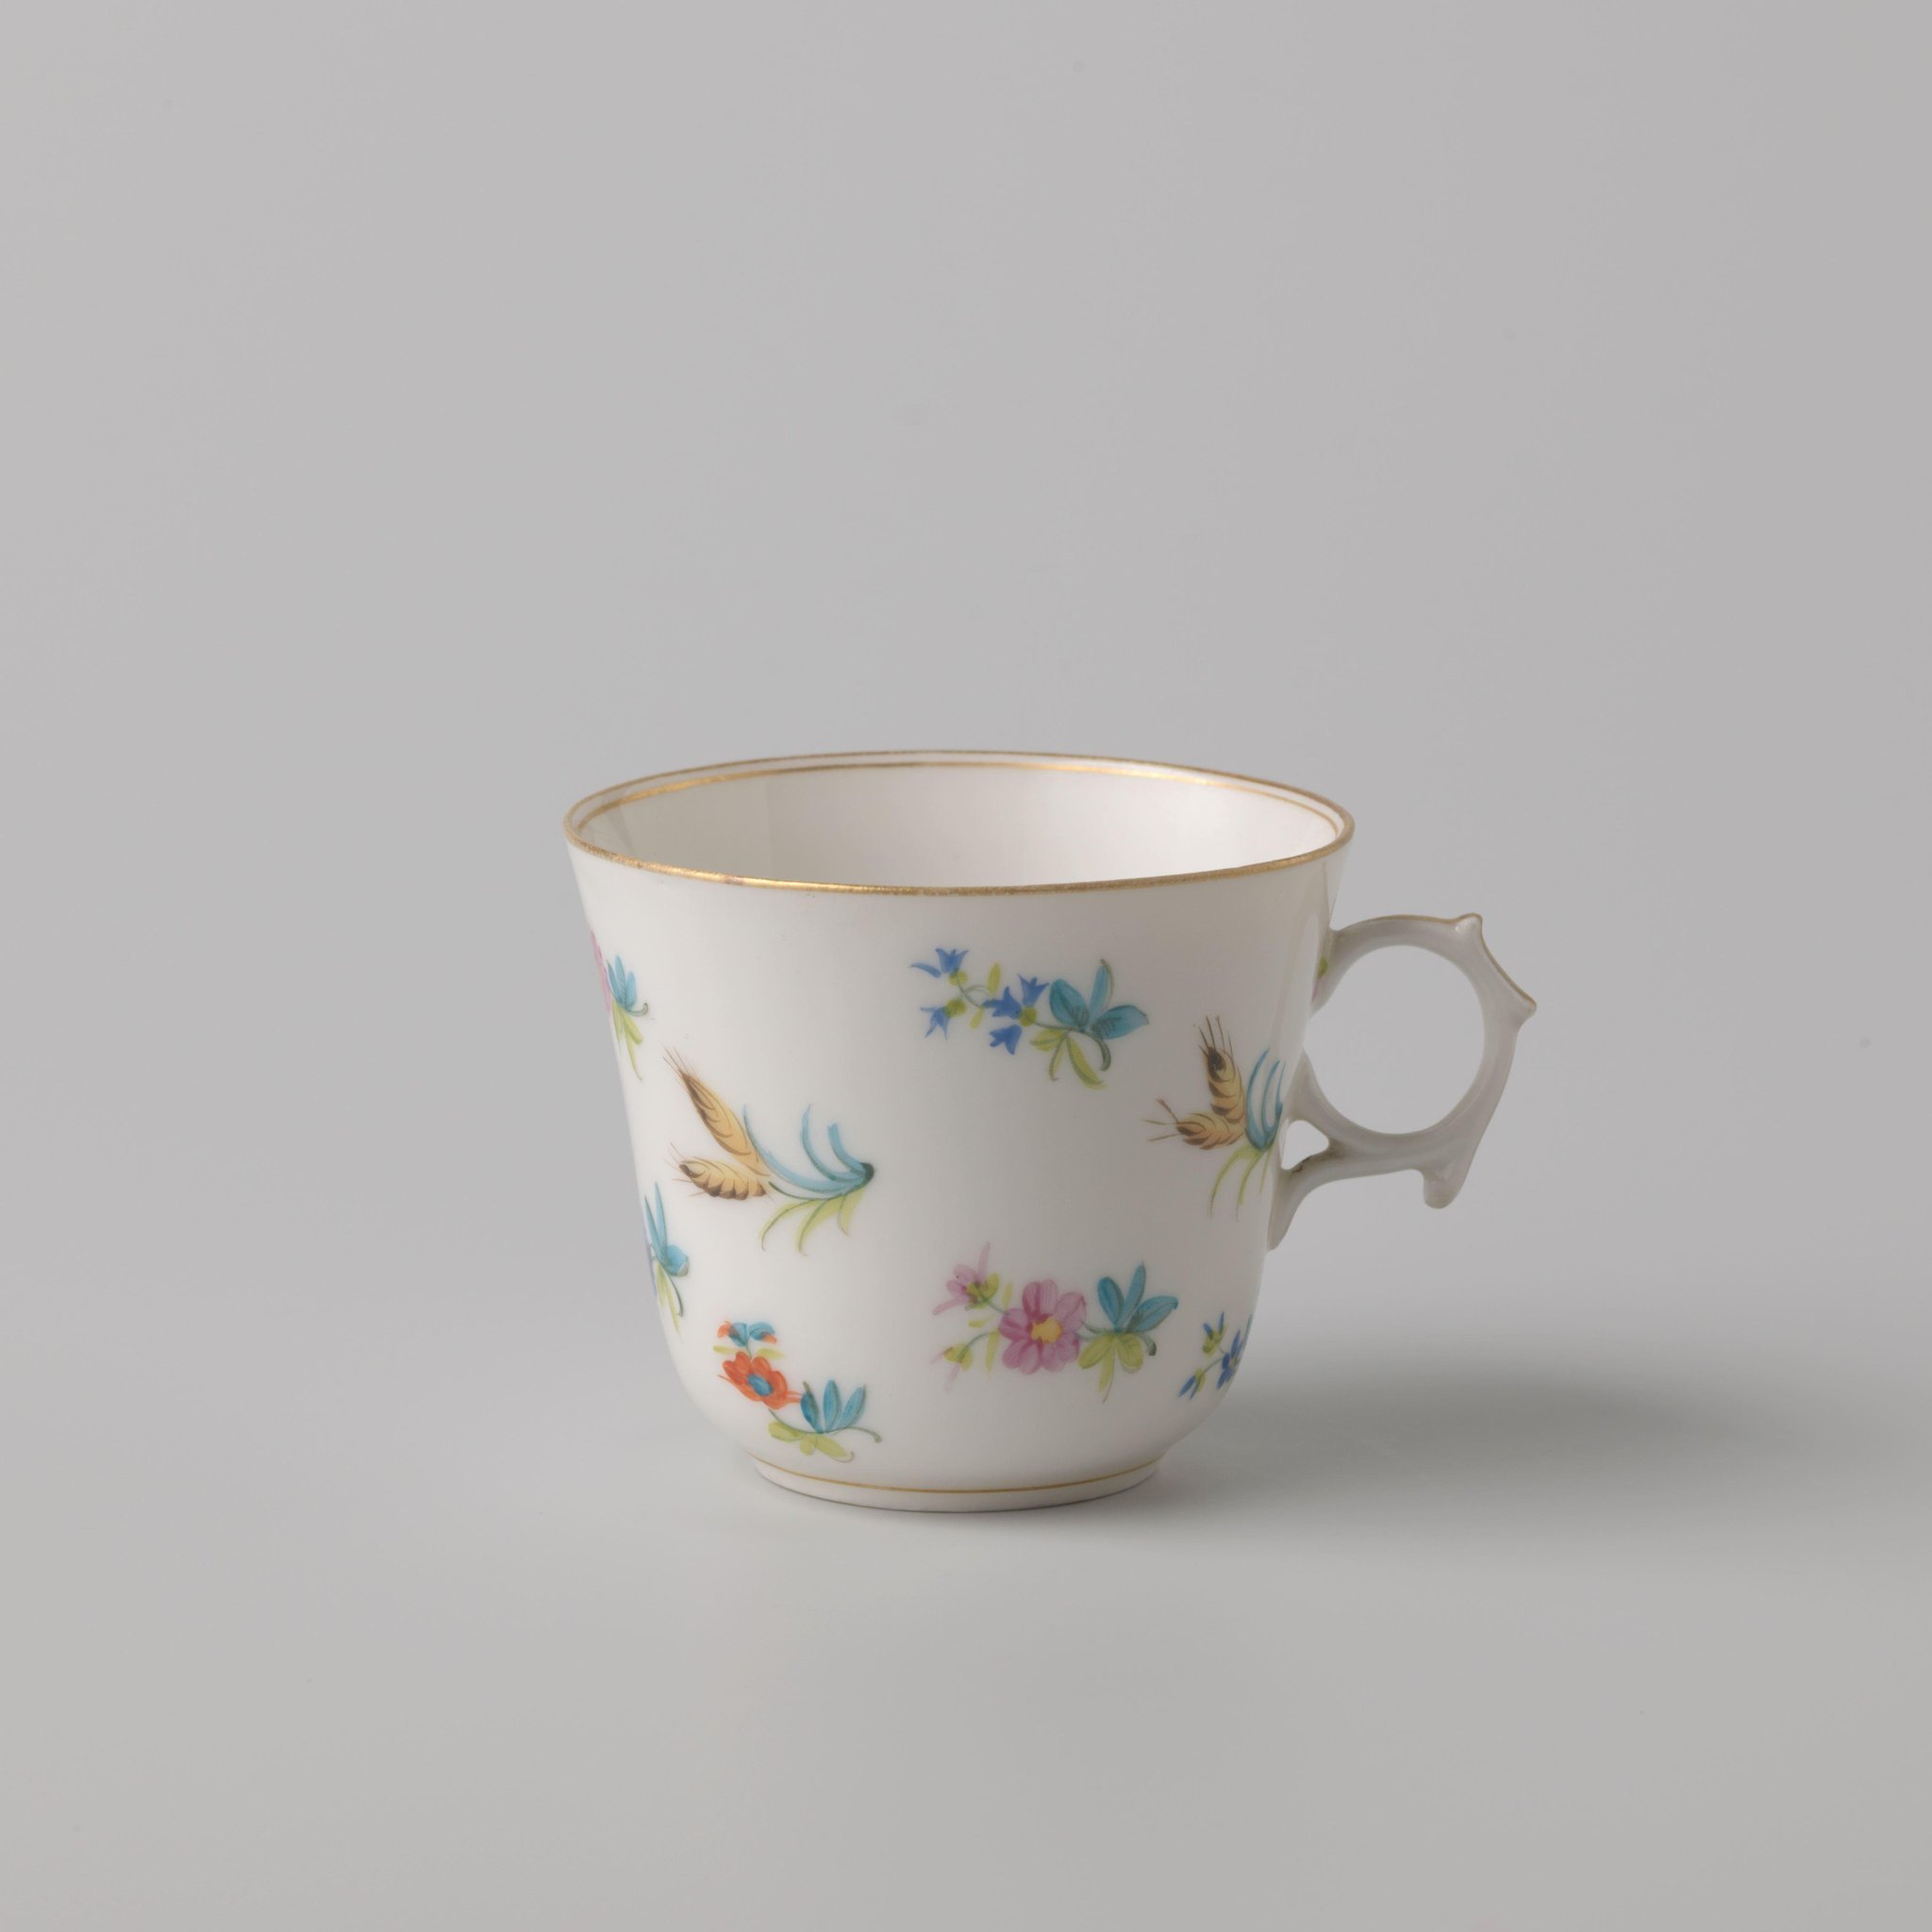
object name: cup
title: Cup with flower sprays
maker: Anonymous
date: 1860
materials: glaze, gold, paint, porcelain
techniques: firing, forming, gilding, turning, vitrification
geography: france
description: Kop van porselein met een hoekig oor, beschilderd op het glazuur in blauw, rood, roze, groen, geel, bruin en goud. Op de buitenwand bloemtakken en gouden lijn op de rand en voet. De bodem met een gouden cirkel.